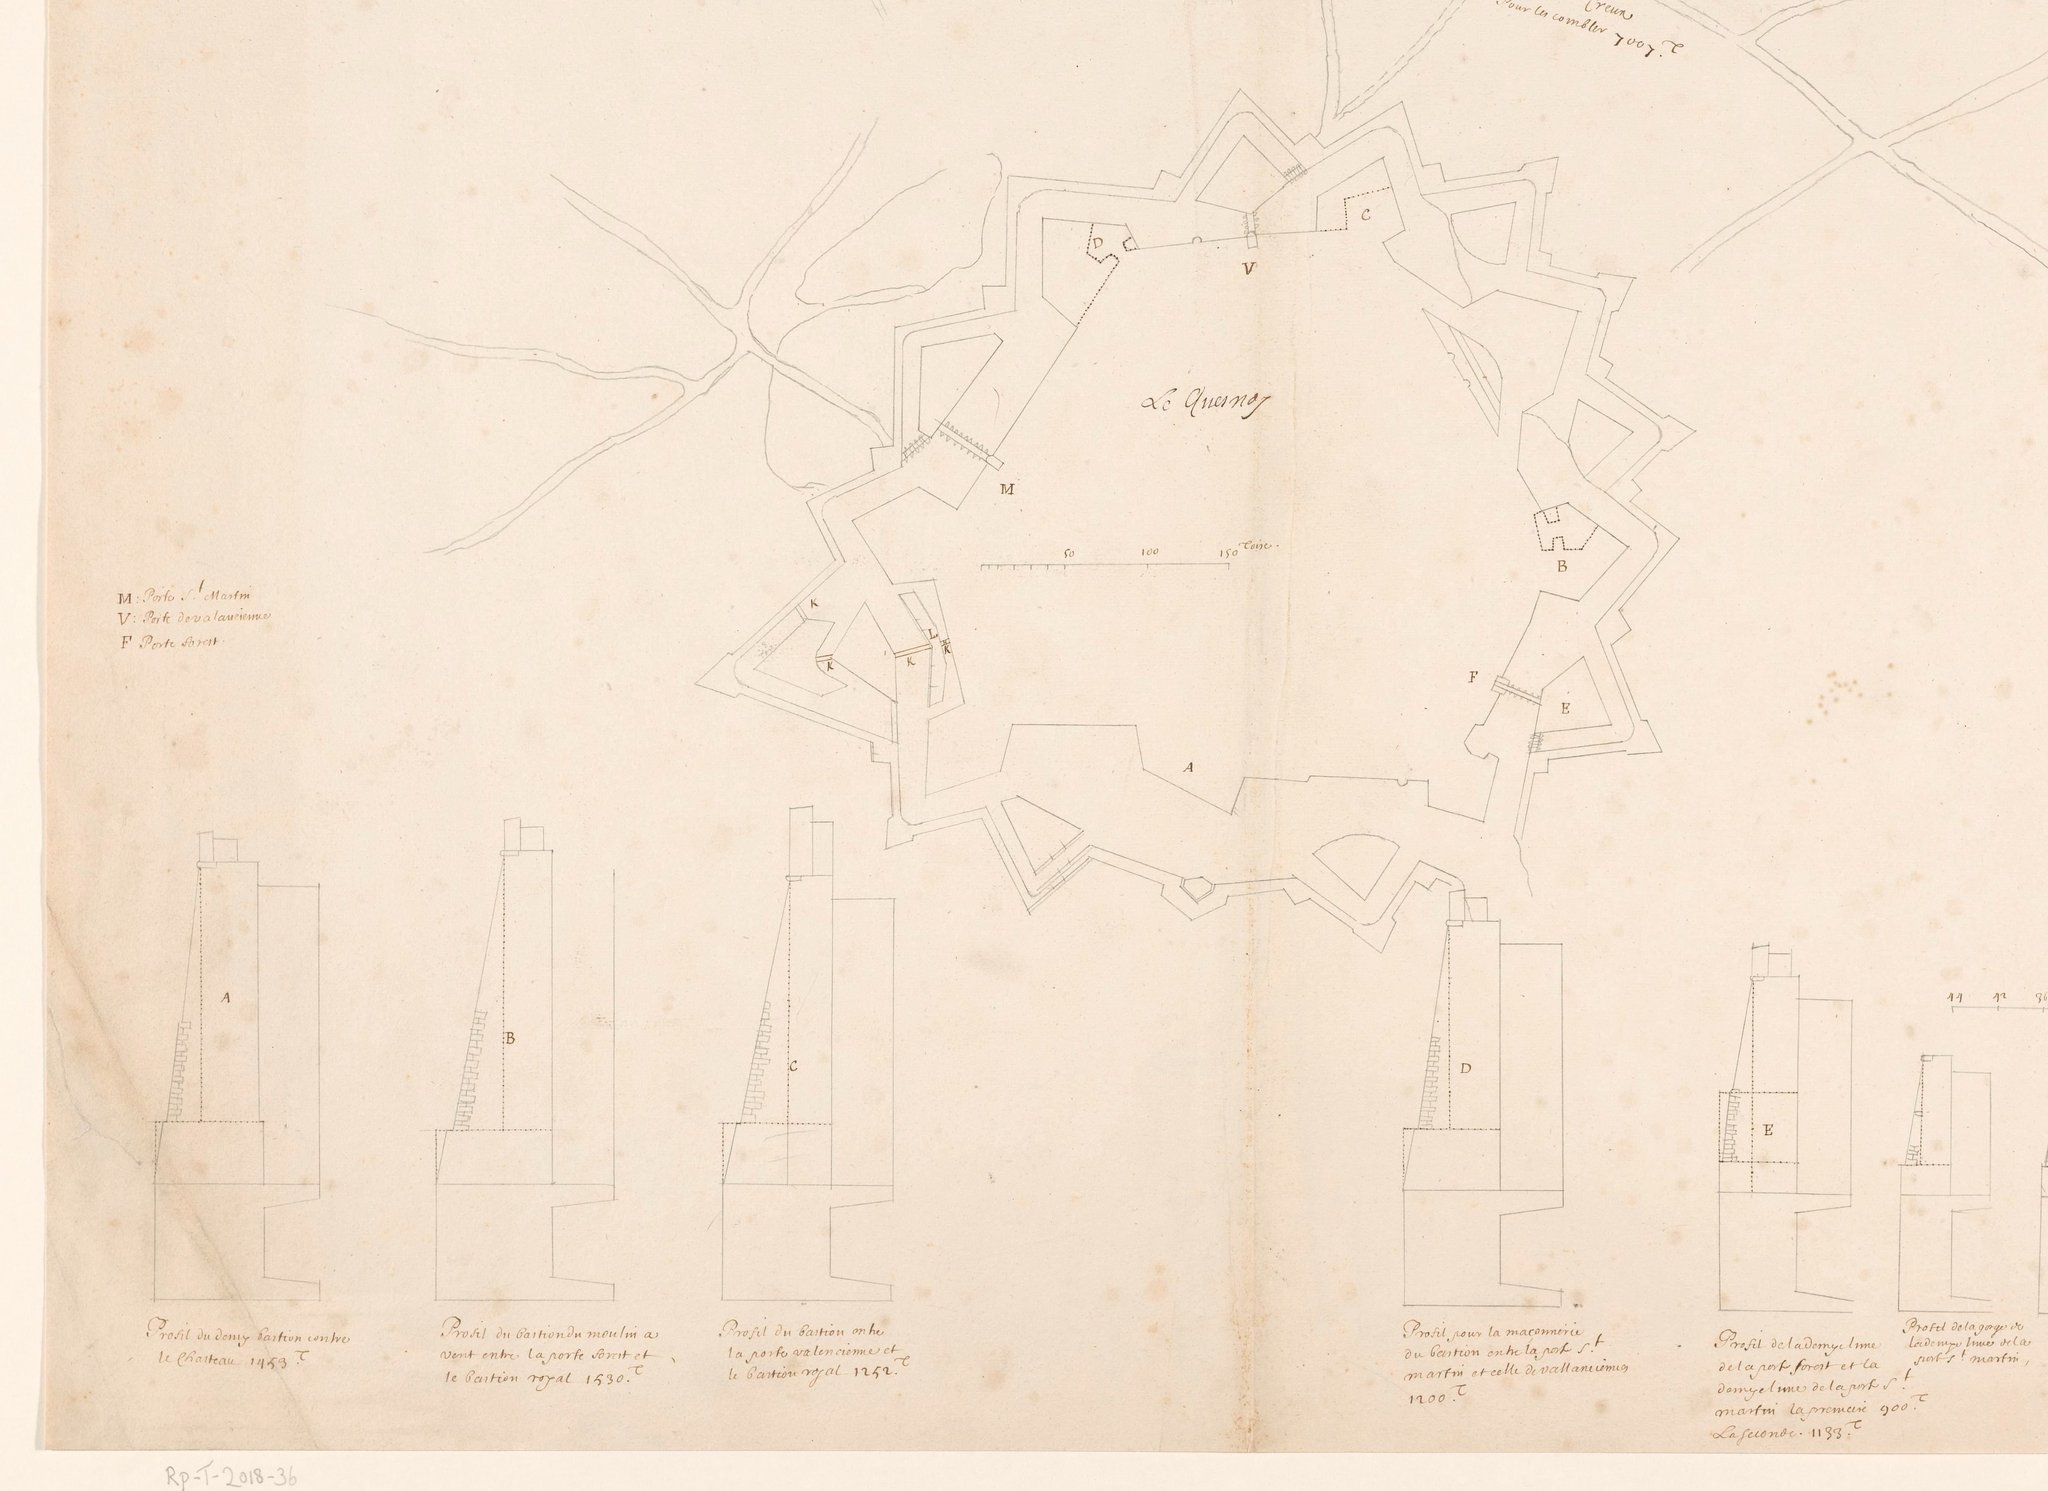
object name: drawing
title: Vestingplattegrond van Le Quesnoy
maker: Anonymous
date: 1700-1799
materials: ink, paper, pencil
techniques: pen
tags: fortified city, maps of cities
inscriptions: collector's mark: Lugt 2228